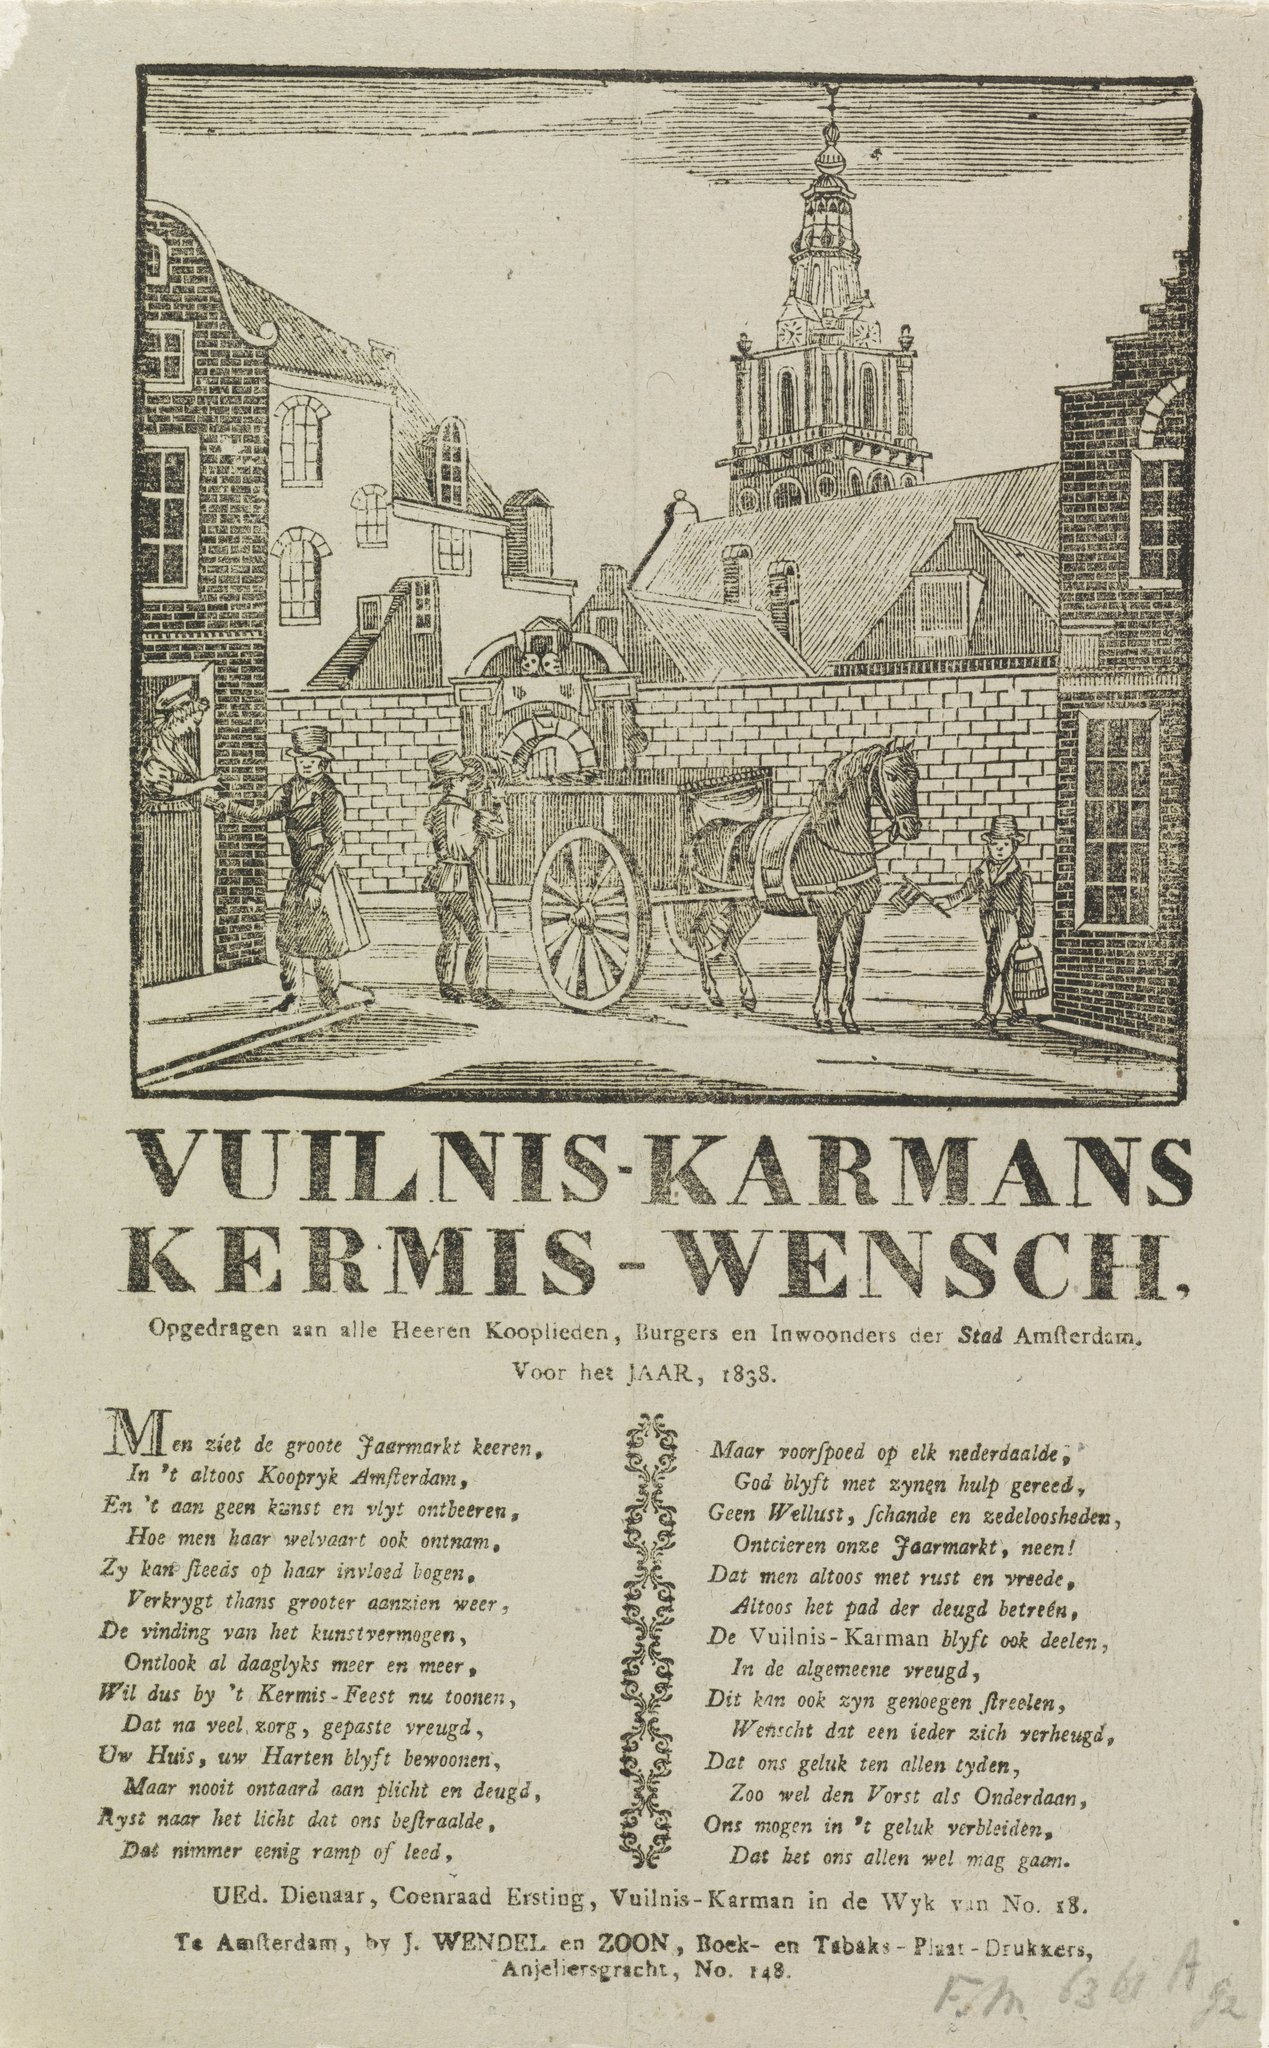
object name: print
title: Kermisprent van de vuilnismannen van Amsterdam voor het jaar 1838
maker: Anonymous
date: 1838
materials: paper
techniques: letterpress printing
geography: amsterdam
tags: street, garbage collection, amsterdam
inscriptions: collector's mark: Lugt 2228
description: Kermisprent van de Amsterdamse vuilnismannen voor het jaar 1838. Gezicht bij de Sint-Antoniesbreestraat en het poortje naar de Zuiderkerkhof bij de Zuiderkerk te Amsterdam, waar een man een vuilnisemmer in de kar leegkiepert en een andere man met de ratel draait. Een andere man haalt bij een huis geld op. Met gedicht in twee kolommen. Van de vuilniskarman in de wijk no. 18: Coenraad Ersting.